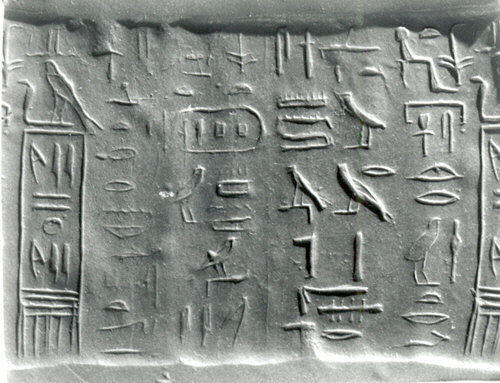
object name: cylinder seal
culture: egyptian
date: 2289-2255 BCE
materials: stone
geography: egypt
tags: hieroglyphs